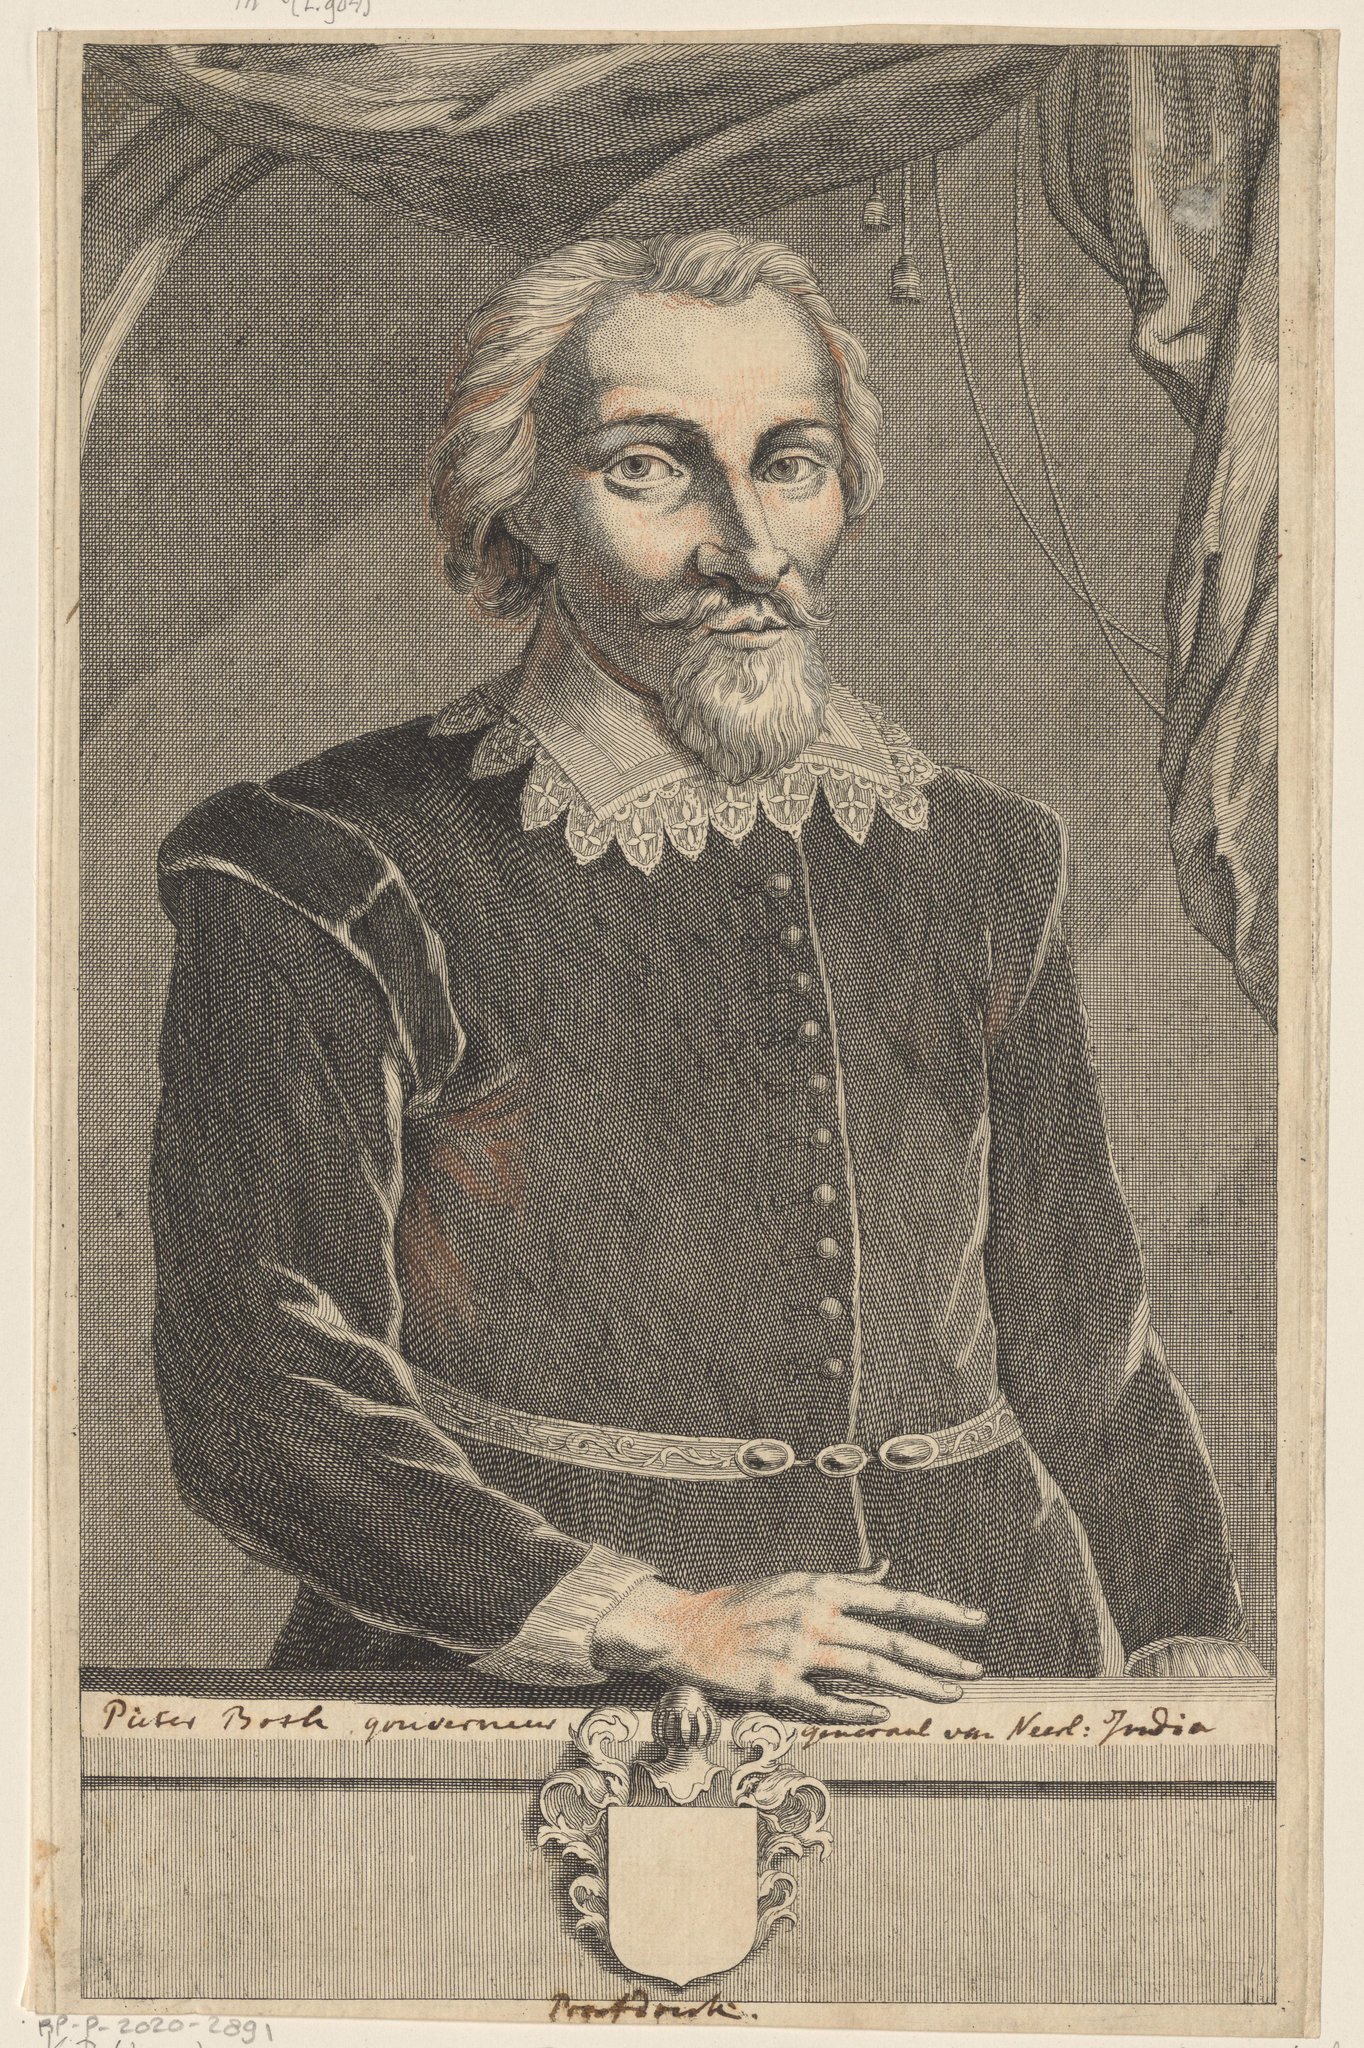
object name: print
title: Portret van Pieter Both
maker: Anonymous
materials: chalk, paper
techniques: engraving, etching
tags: colonial governor, historical persons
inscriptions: collector's mark: Lugt 240, inscription: ‘Pieter Both gouverneur generaal van Neerl: India/ proefdruk.’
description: Latere staat van de prent gebruikt in: Valentijn, François. Oud en nieuw Oost-Indiën (...). Dordrecht en Amsterdam: Johannes van Braam en Gerard onder de Linden, 1726, dl. 4.